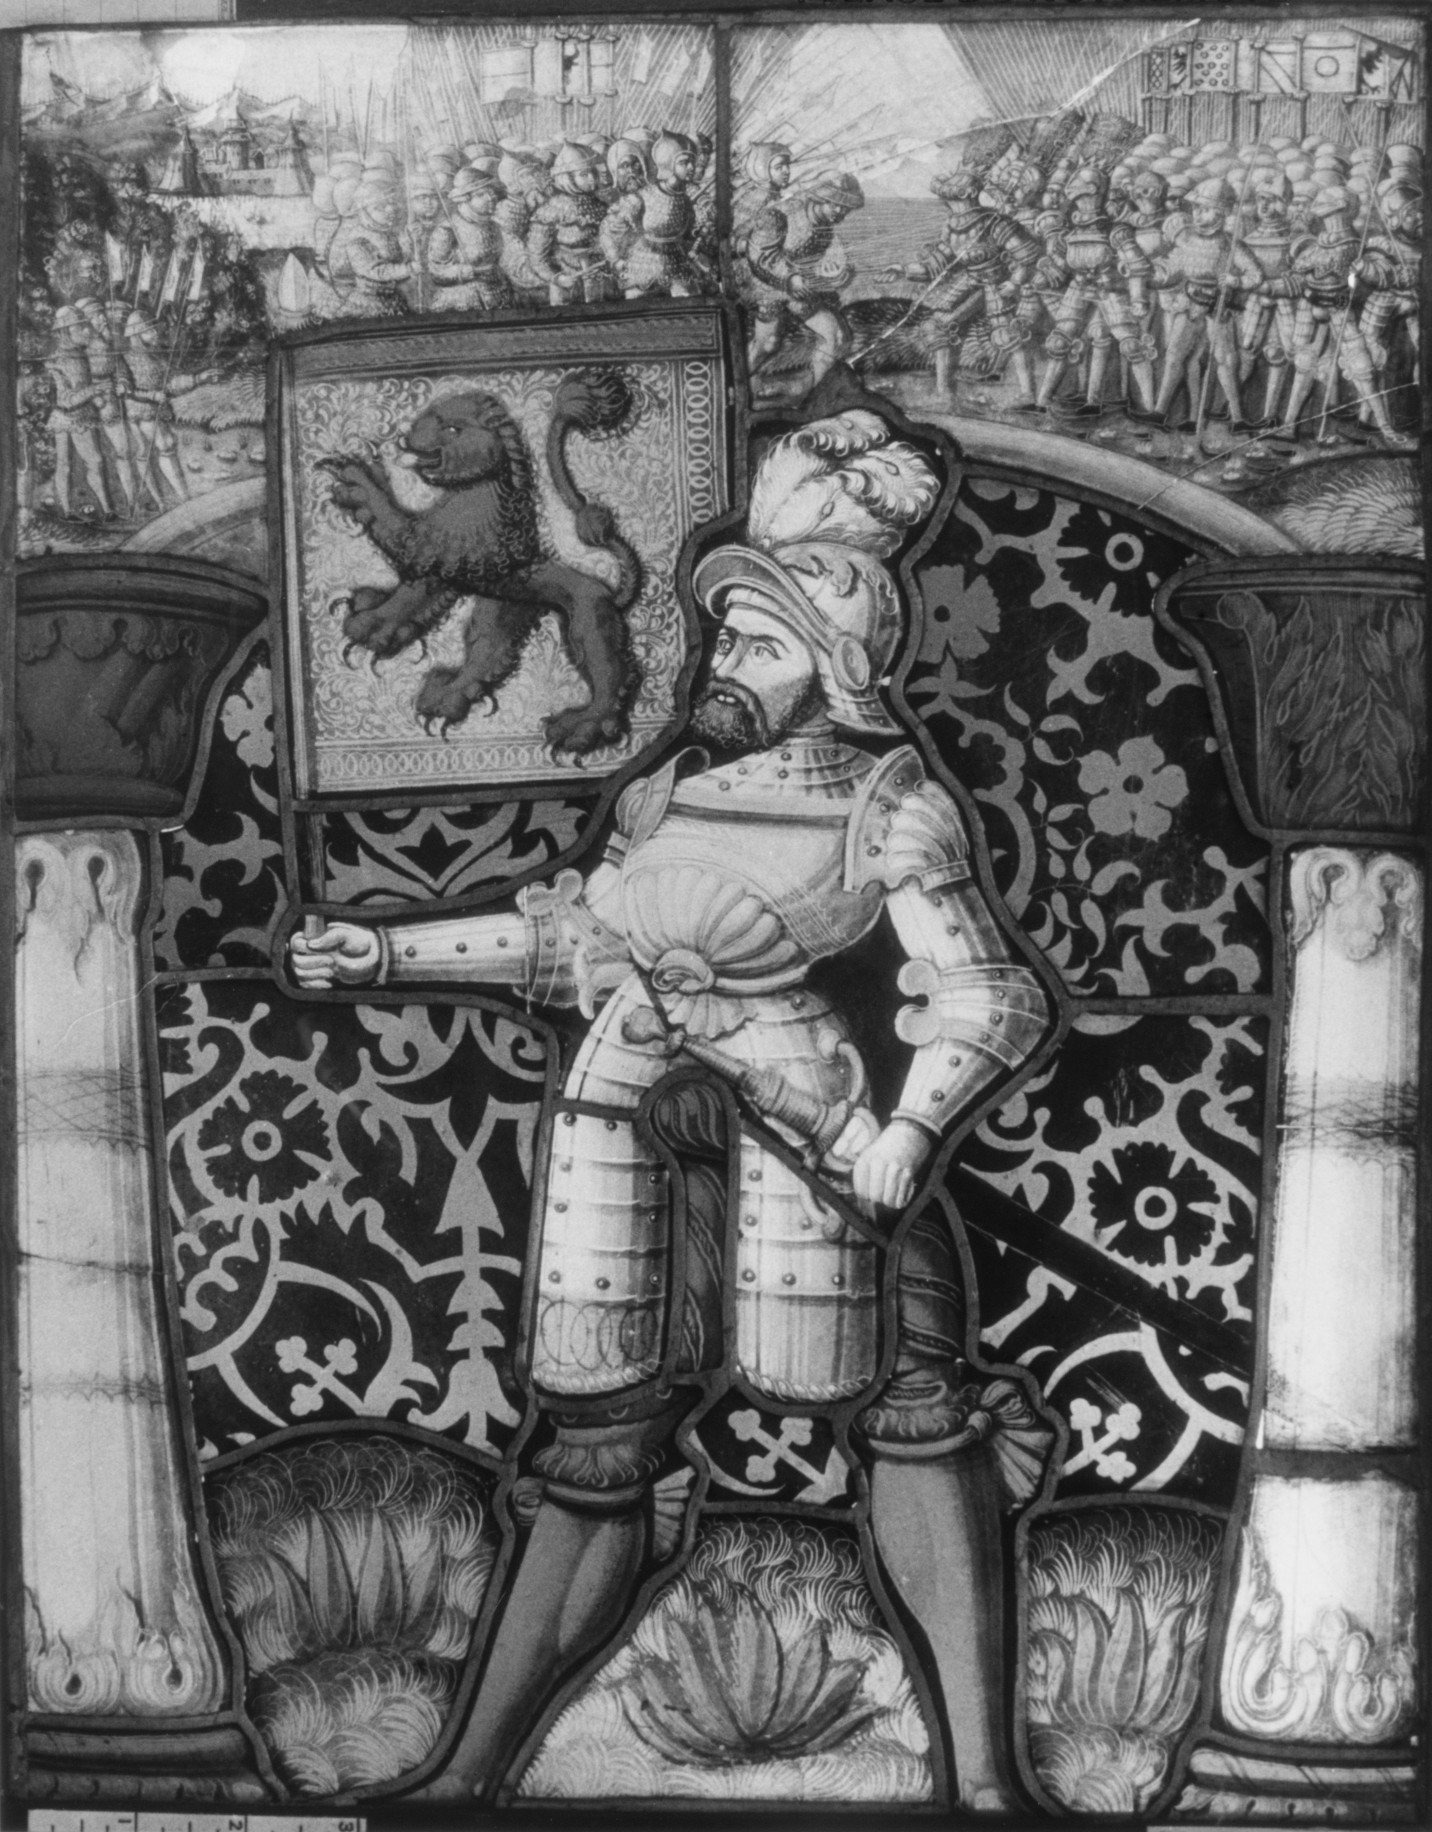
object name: panel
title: Ensign with flag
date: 1560-1580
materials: glass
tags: soldiers,swords,men,lions,flags